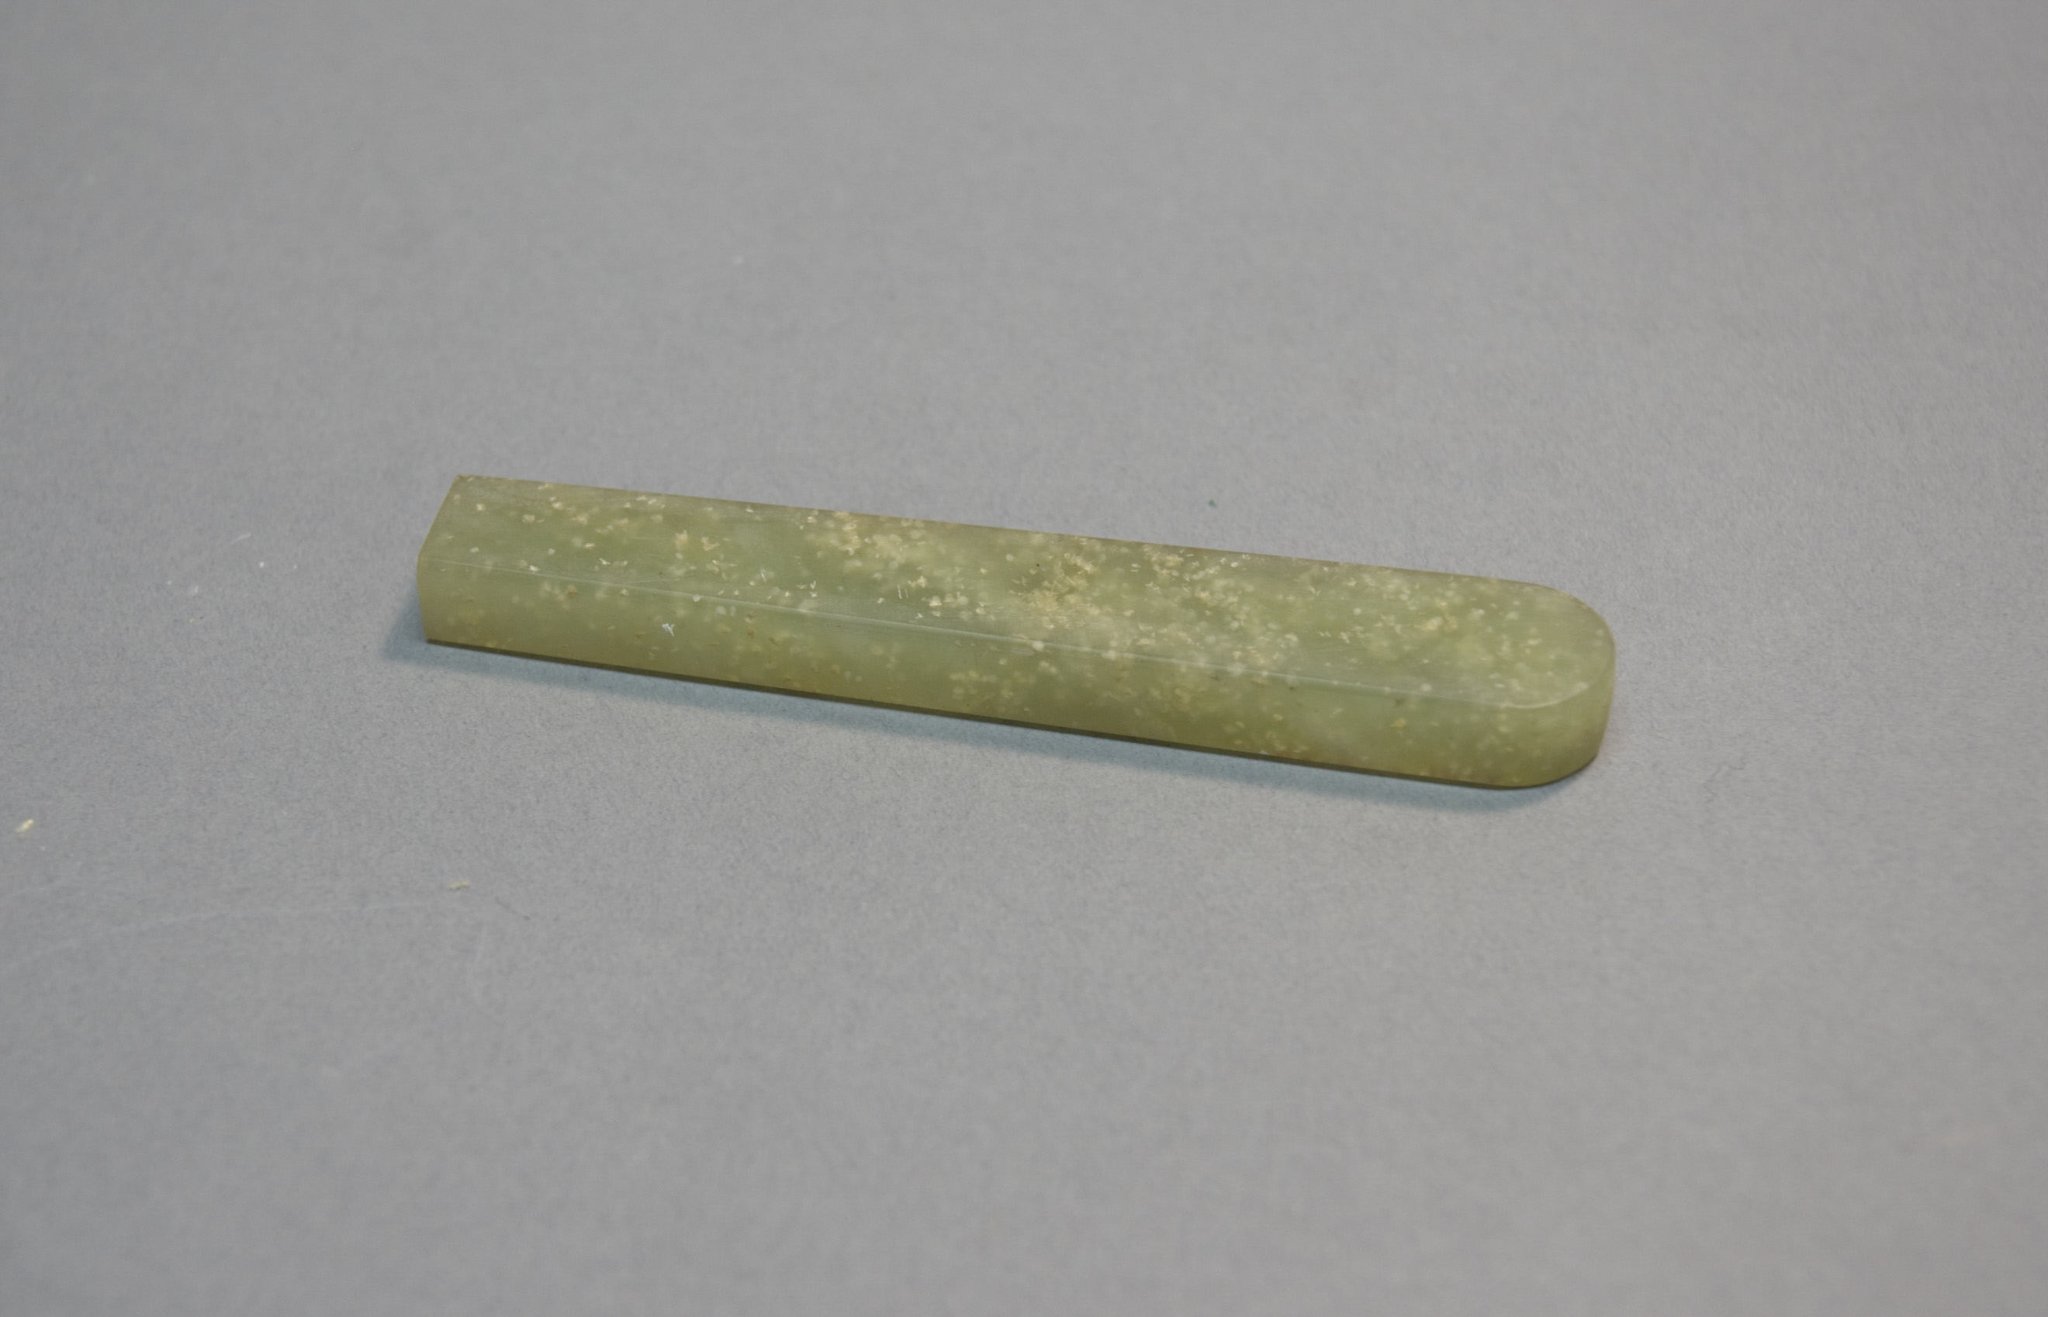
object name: jade carving material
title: Sample of Serpentine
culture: chinese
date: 1901-2000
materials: stone